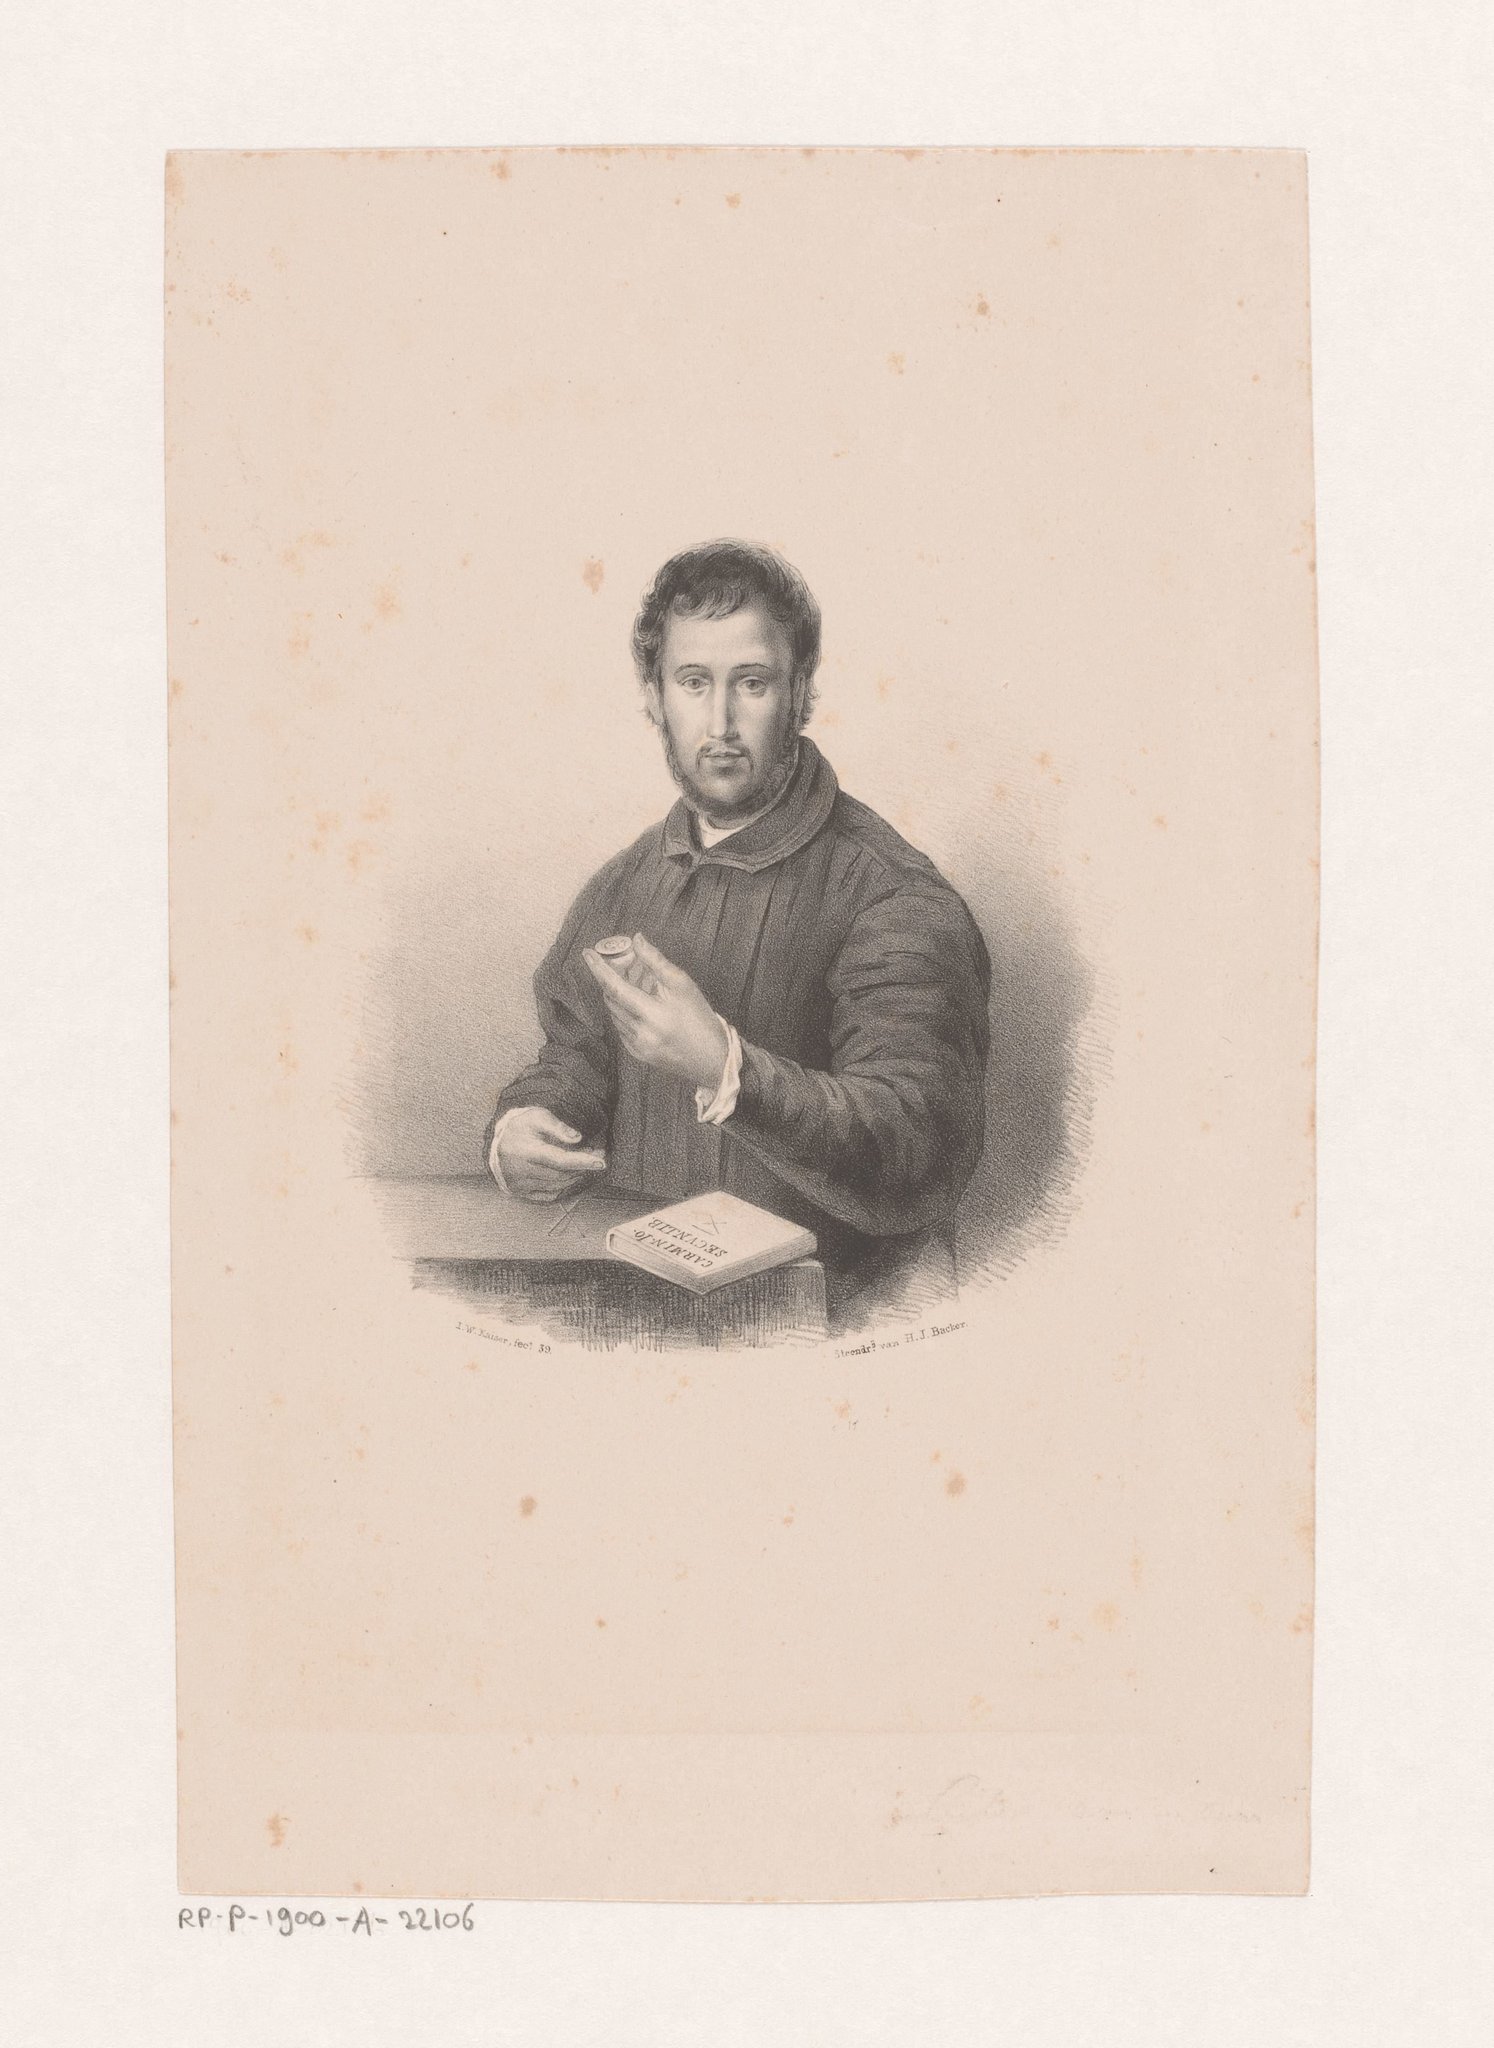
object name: print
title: Portret van Janus Secundus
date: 1839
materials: paper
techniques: lithograph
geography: dordrecht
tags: the hague, janus secundus, book, historical persons (+ half-length portrait), coin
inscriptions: collector's mark: Lugt 2228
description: De geportretteerde heeft een munt met daarop een portret in zijn linkerhand. Voor hem op tafel liggen een boek met de titel: Carmin. Io Secvn. Lib. en graveernaalden. Naar een prent door Jan van Scorel.